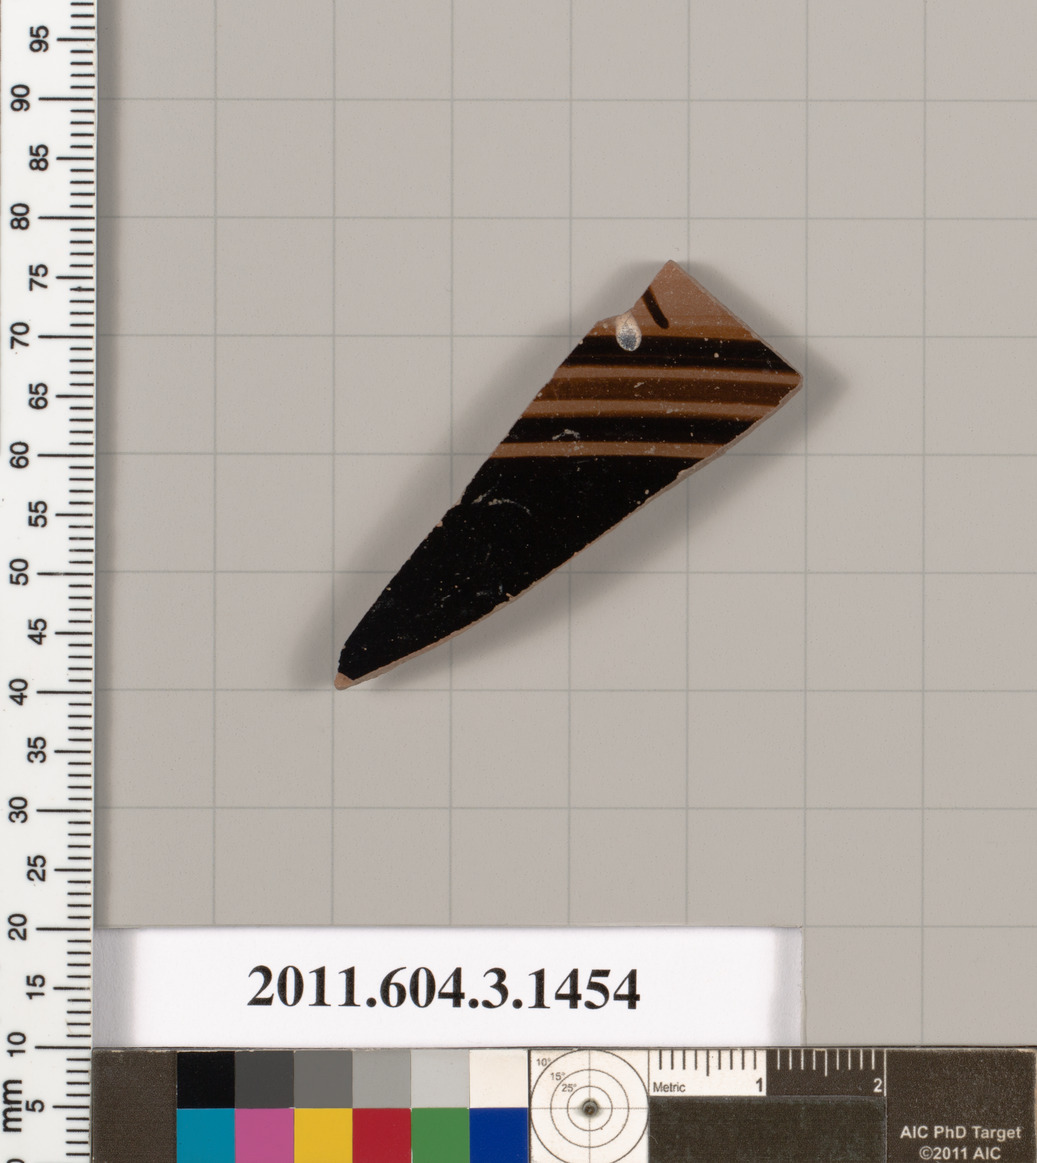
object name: skyphos fragment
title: Terracotta fragment of a skyphos (deep drinking cup)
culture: greek, attic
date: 534-468 BCE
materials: terracotta